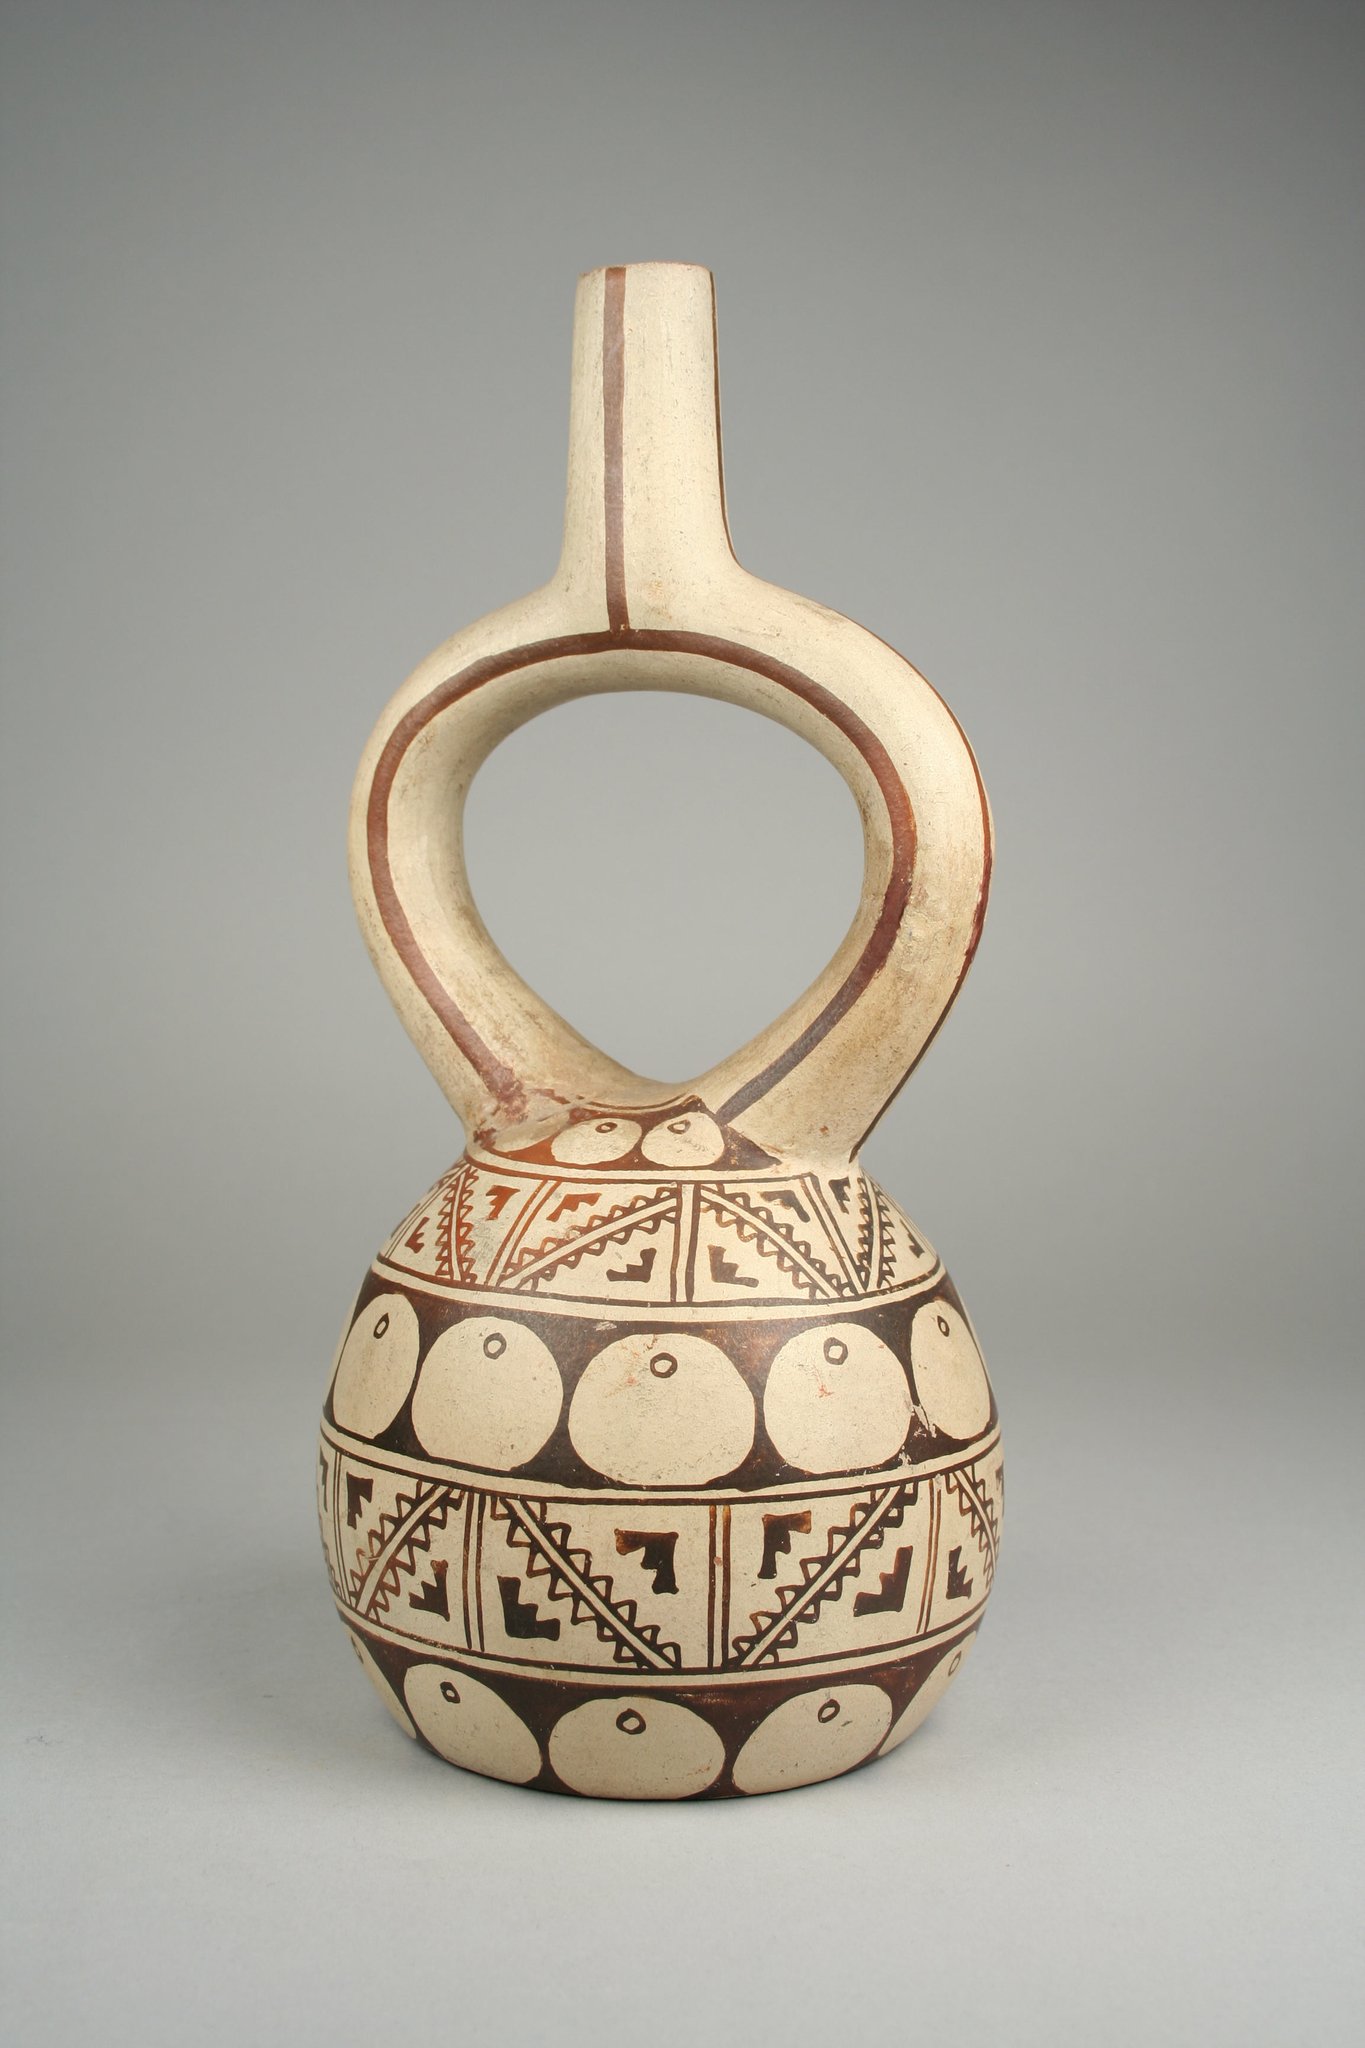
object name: bottle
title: Geometric Pattern Bottle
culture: moche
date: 401-700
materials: ceramic, pigment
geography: peru